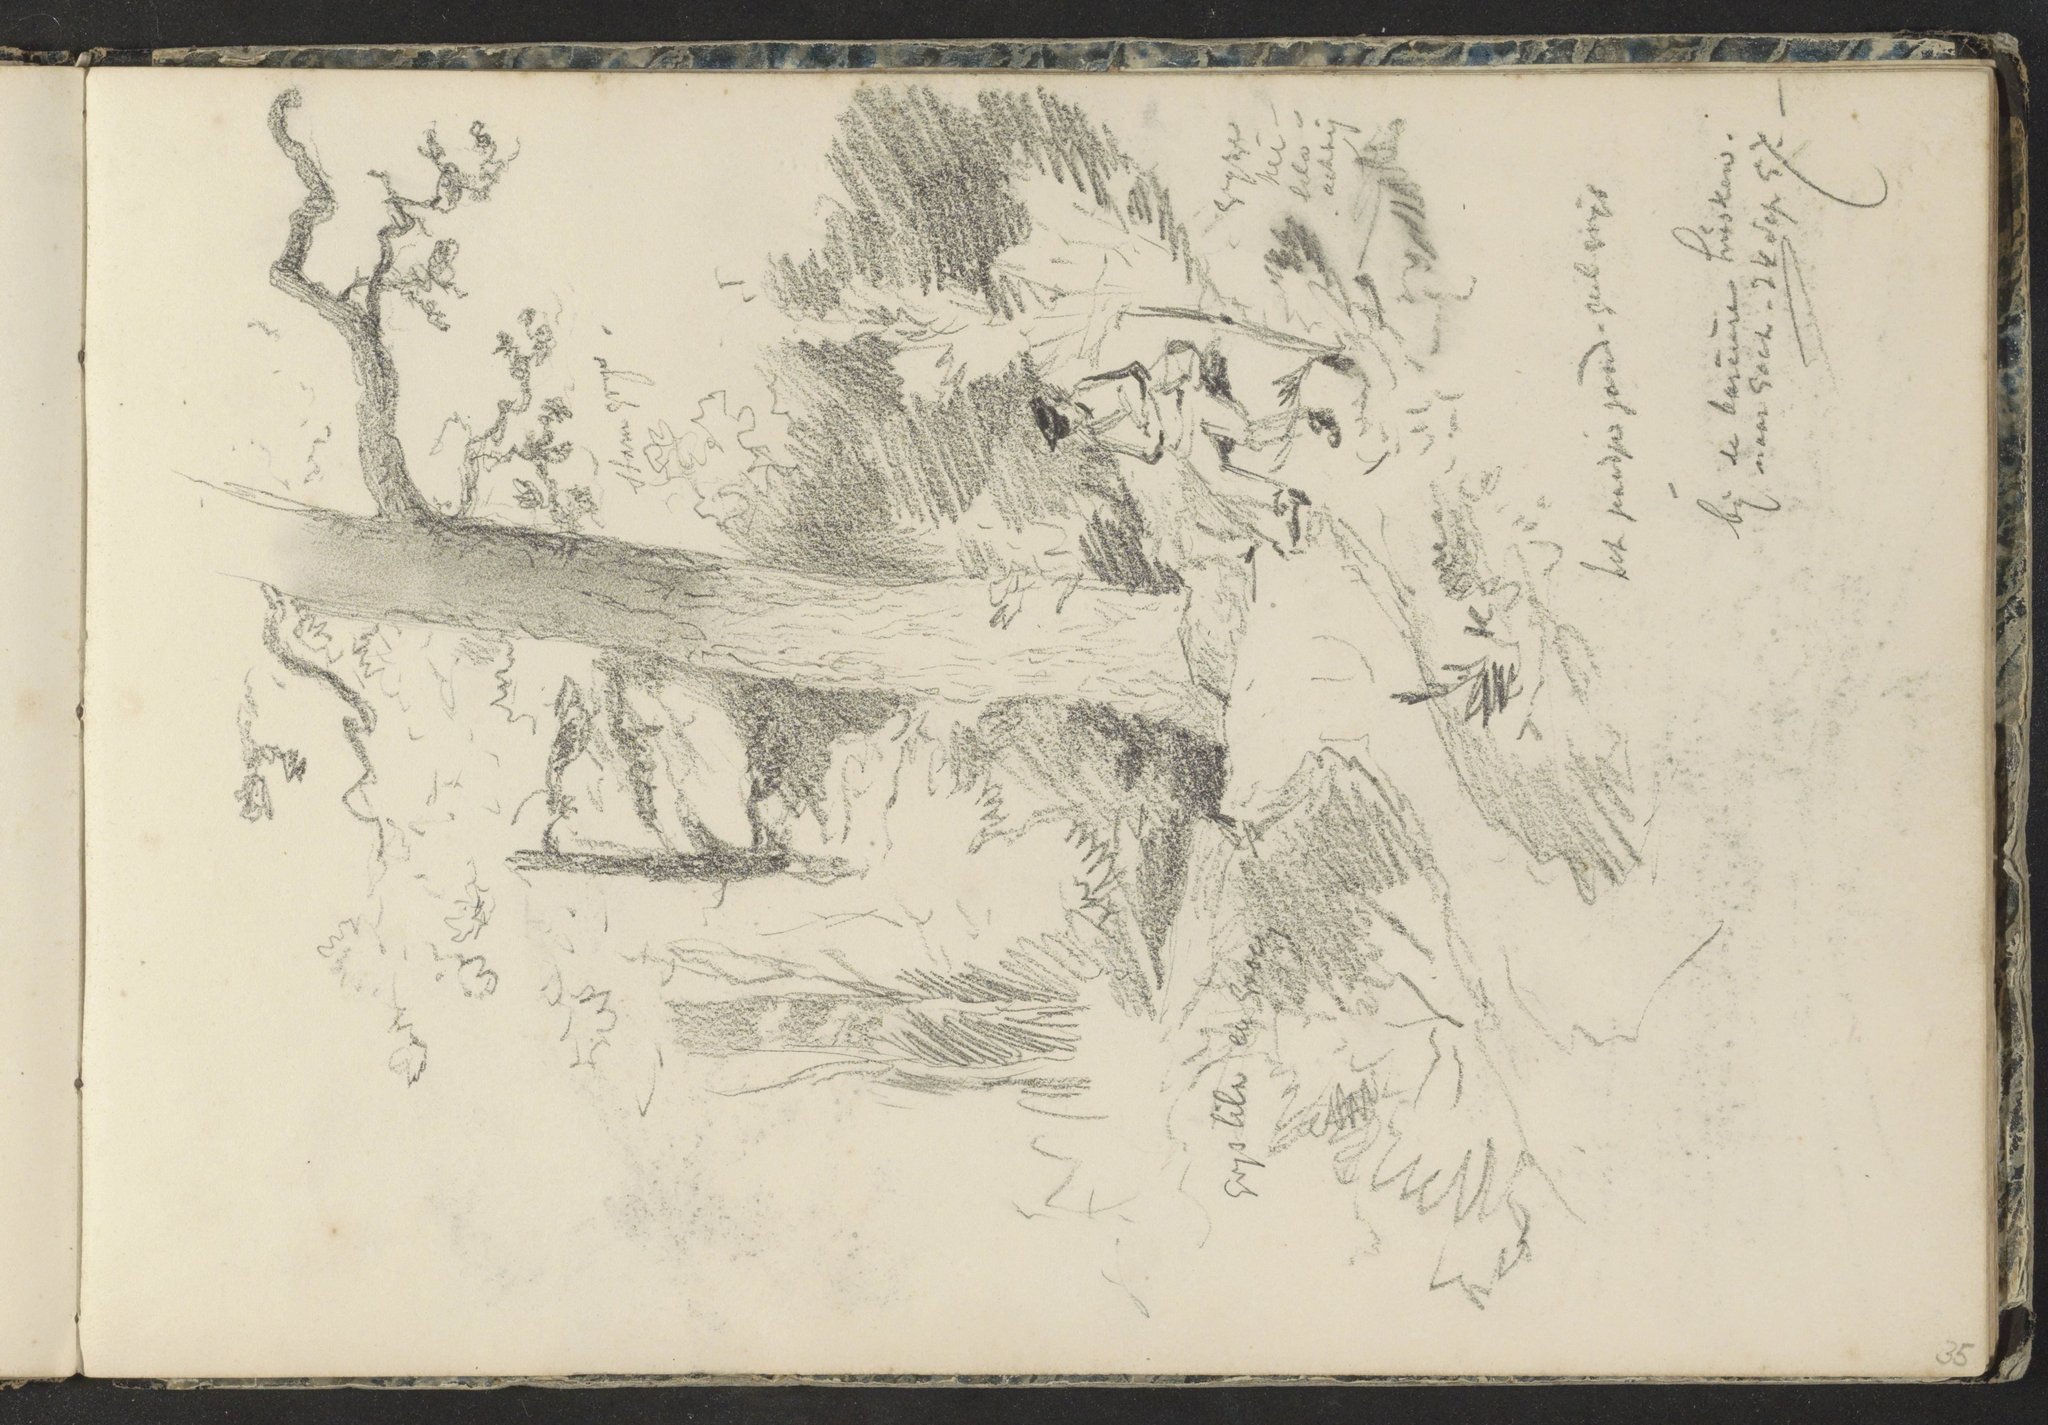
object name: sketchbook leaf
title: Figuur op een steen bij een bospad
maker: johannes tavenraat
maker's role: draughtsman, painter, print maker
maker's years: 1809-1881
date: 1809-1857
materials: paper, pencil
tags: sitting figure, road, path, forest, wood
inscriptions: date and inscription: ‘bij de barriere L[...]skens/ naar Sach - 24 Sep 57’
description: Blad 35 recto uit een schetsboek met 44 bladen.